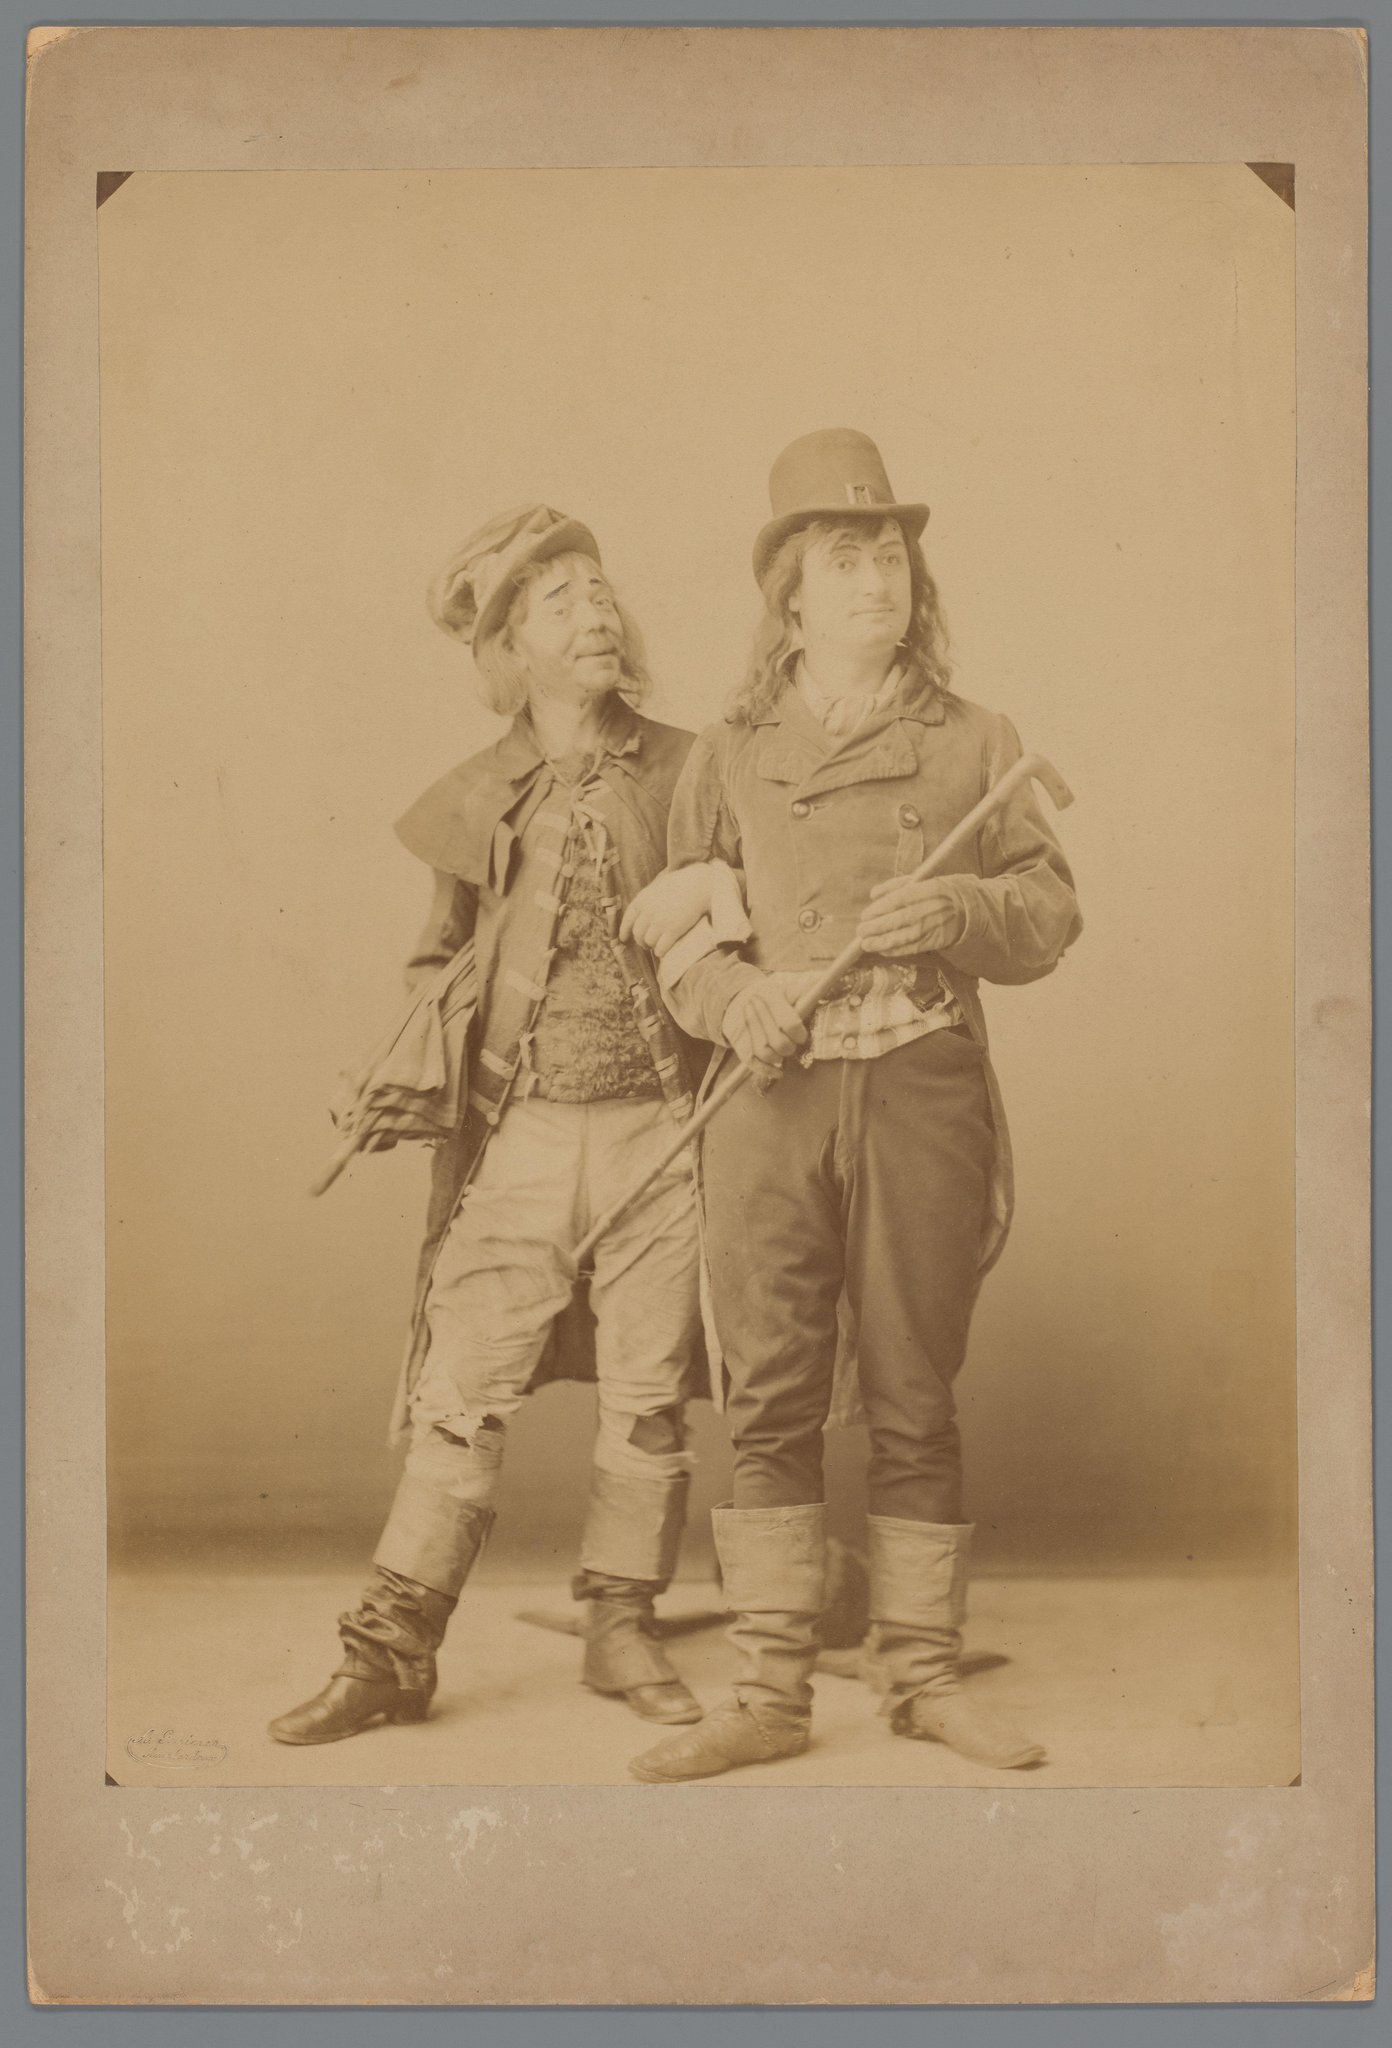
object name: photograph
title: Portret van twee mannen in kostuum, mogelijk toneelspelers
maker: albert greiner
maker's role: fotograaf, fotostudio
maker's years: 1833-1890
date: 1860-1890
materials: cardboard, photographic support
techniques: albumen print, blind stamped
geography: amsterdam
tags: stage costume, walking-stick, staff, historical persons not known by name